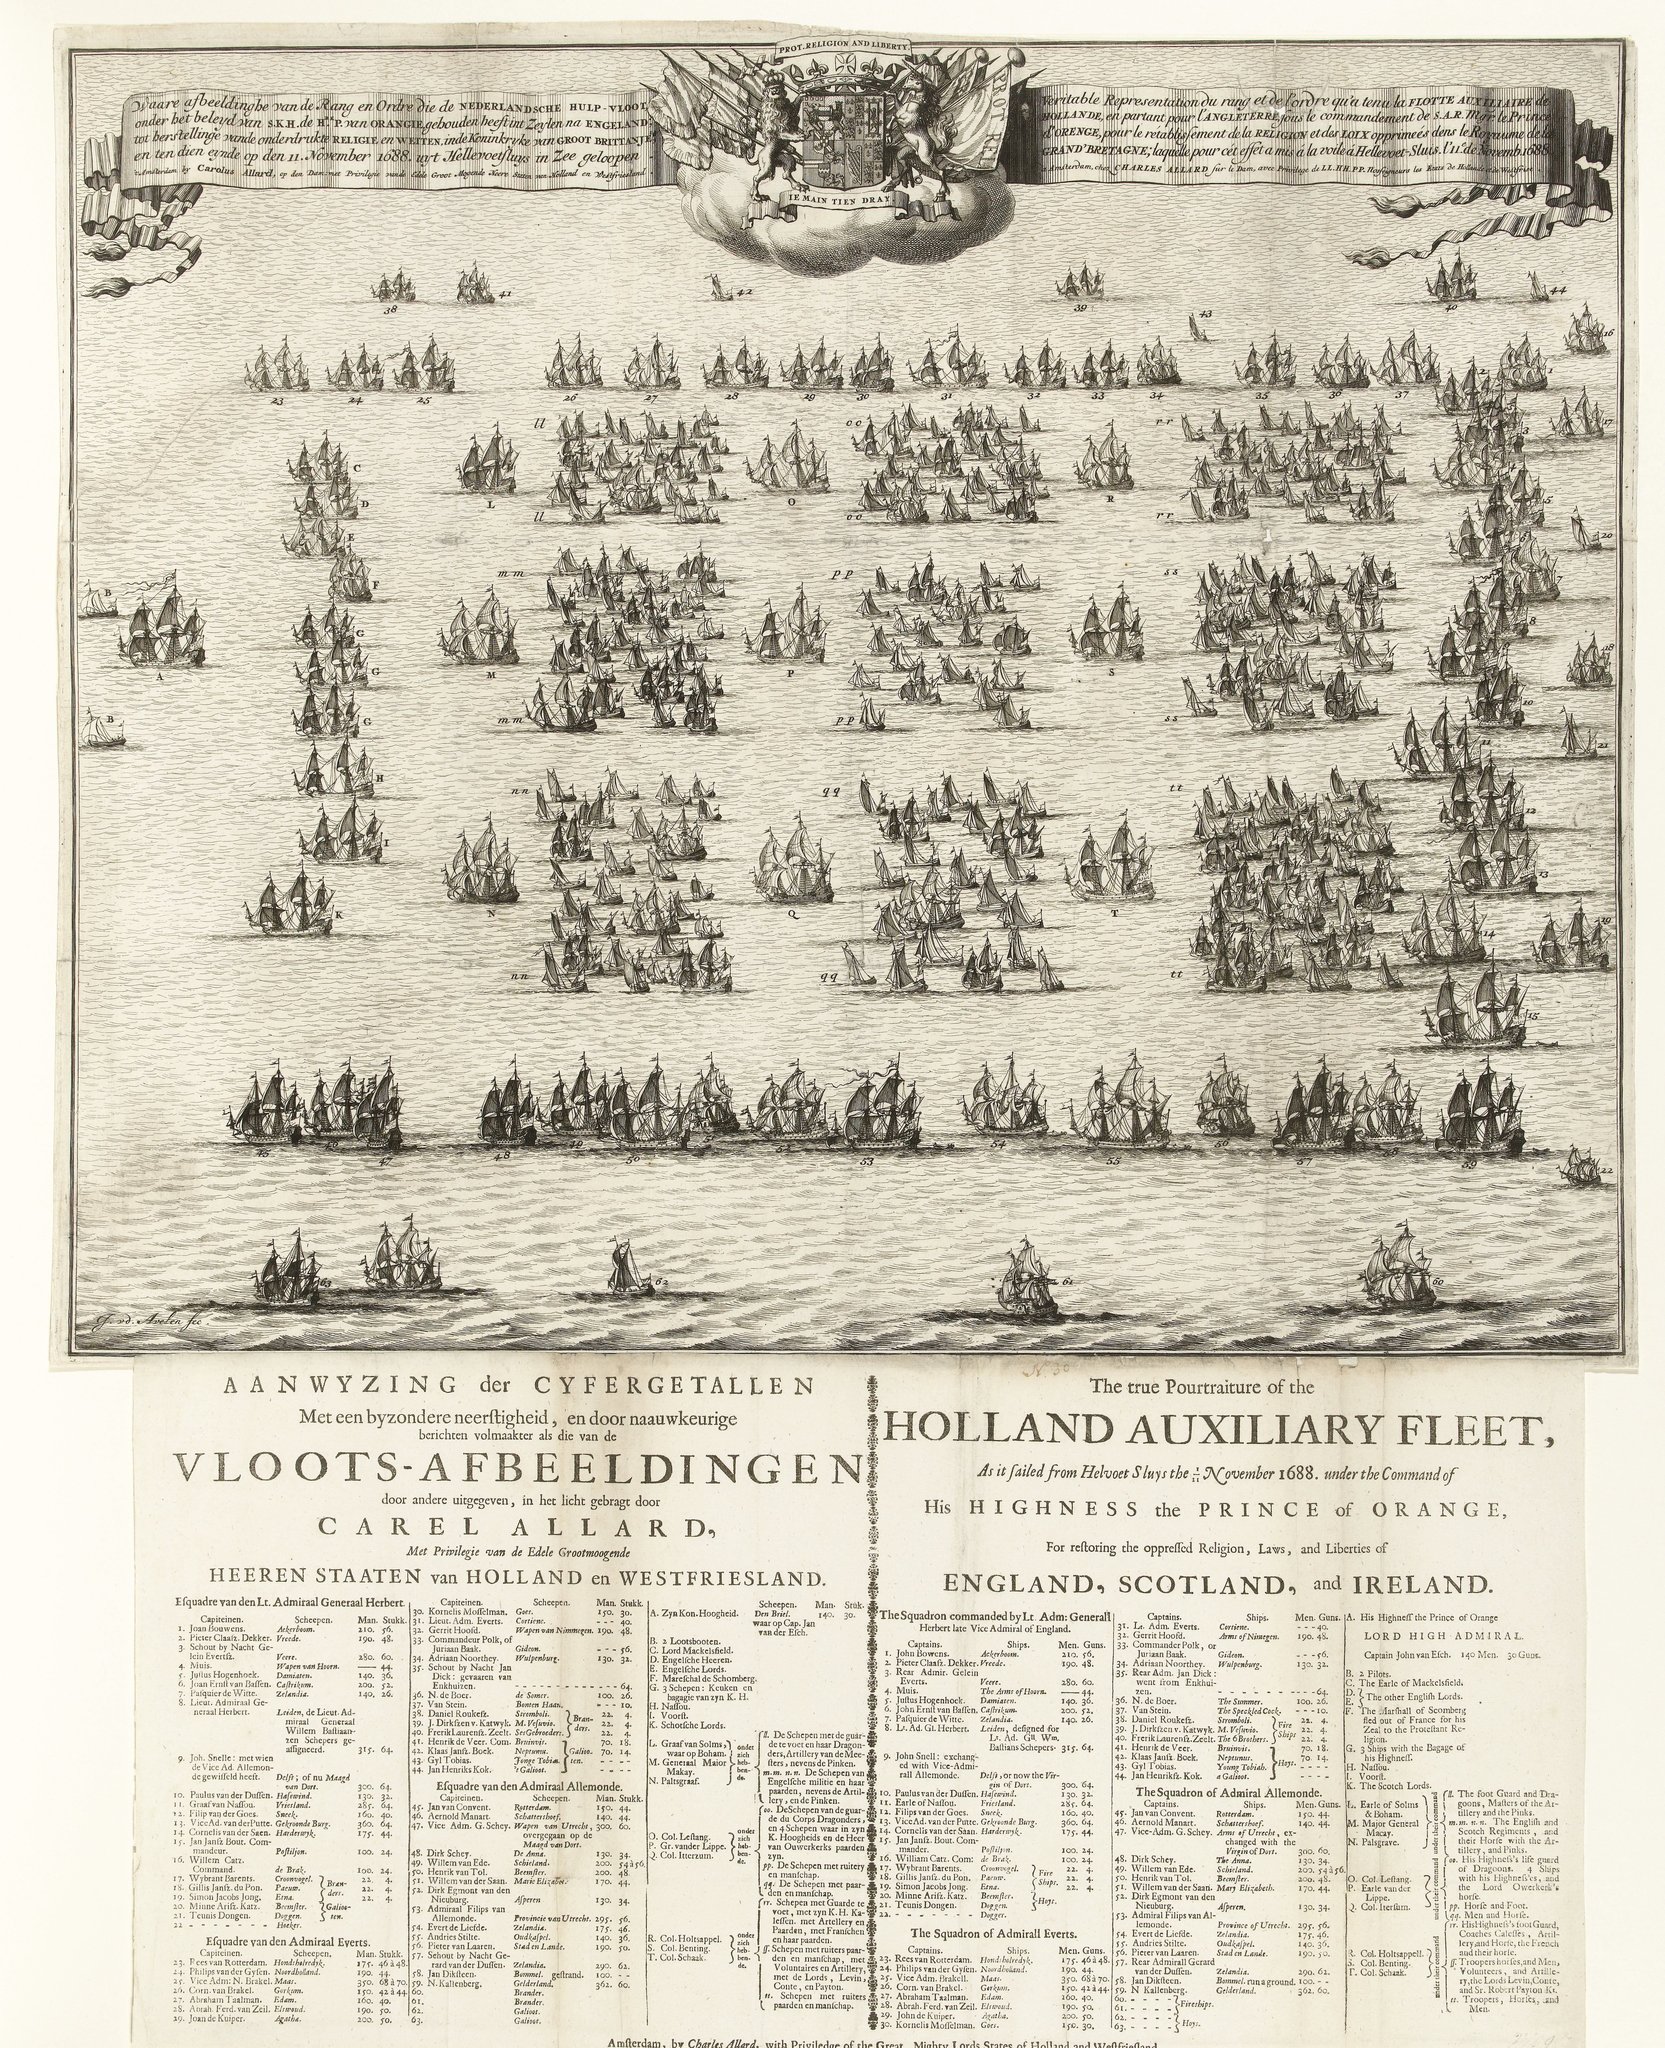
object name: print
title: Waare afbeeldinghe van de Rang en Ordre die de Nederlandsche Hulp-vloot, onder het beleyd van S.K.H. de H.re P. van Orangie, gehouden heeft int Zeylen na Engeland; tot herstellinge vande onderdrukte Religie en Wetten, in de Koninkryke van Groot Brittanje; en ten dien eynde op den 11. November 1688, uyt Hellevoetsluys in Zee geloopen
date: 1688-1689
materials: paper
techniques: etching, letterpress printing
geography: amsterdam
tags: the hague, william iii (prince of orange and king of england, scotland, and ireland), warfare; military affairs (+ sailing-ships)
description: De formatie van de vloot waarmee prins Willem III vanuit Hellevoetsluis naar Engeland is vertrokken, 11 november 1688. Bovenaan het wapen van de stadhouder-koning Willem III met de spreuken 'Prot. Religion and Liberty' en 'Je Maintiendray'. In deze staat middenonderaan een windroos. Vastgeplakt onder de prent een tekstblad met de legenda's 1-63 en A-T in het Nederlands en Engels.